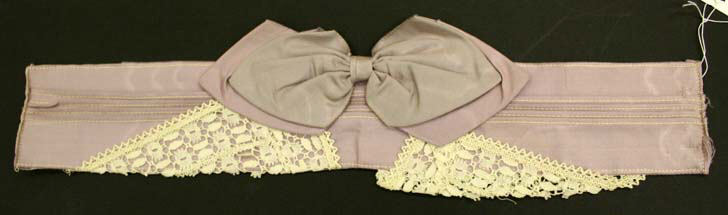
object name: collar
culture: american or european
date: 1700-1945